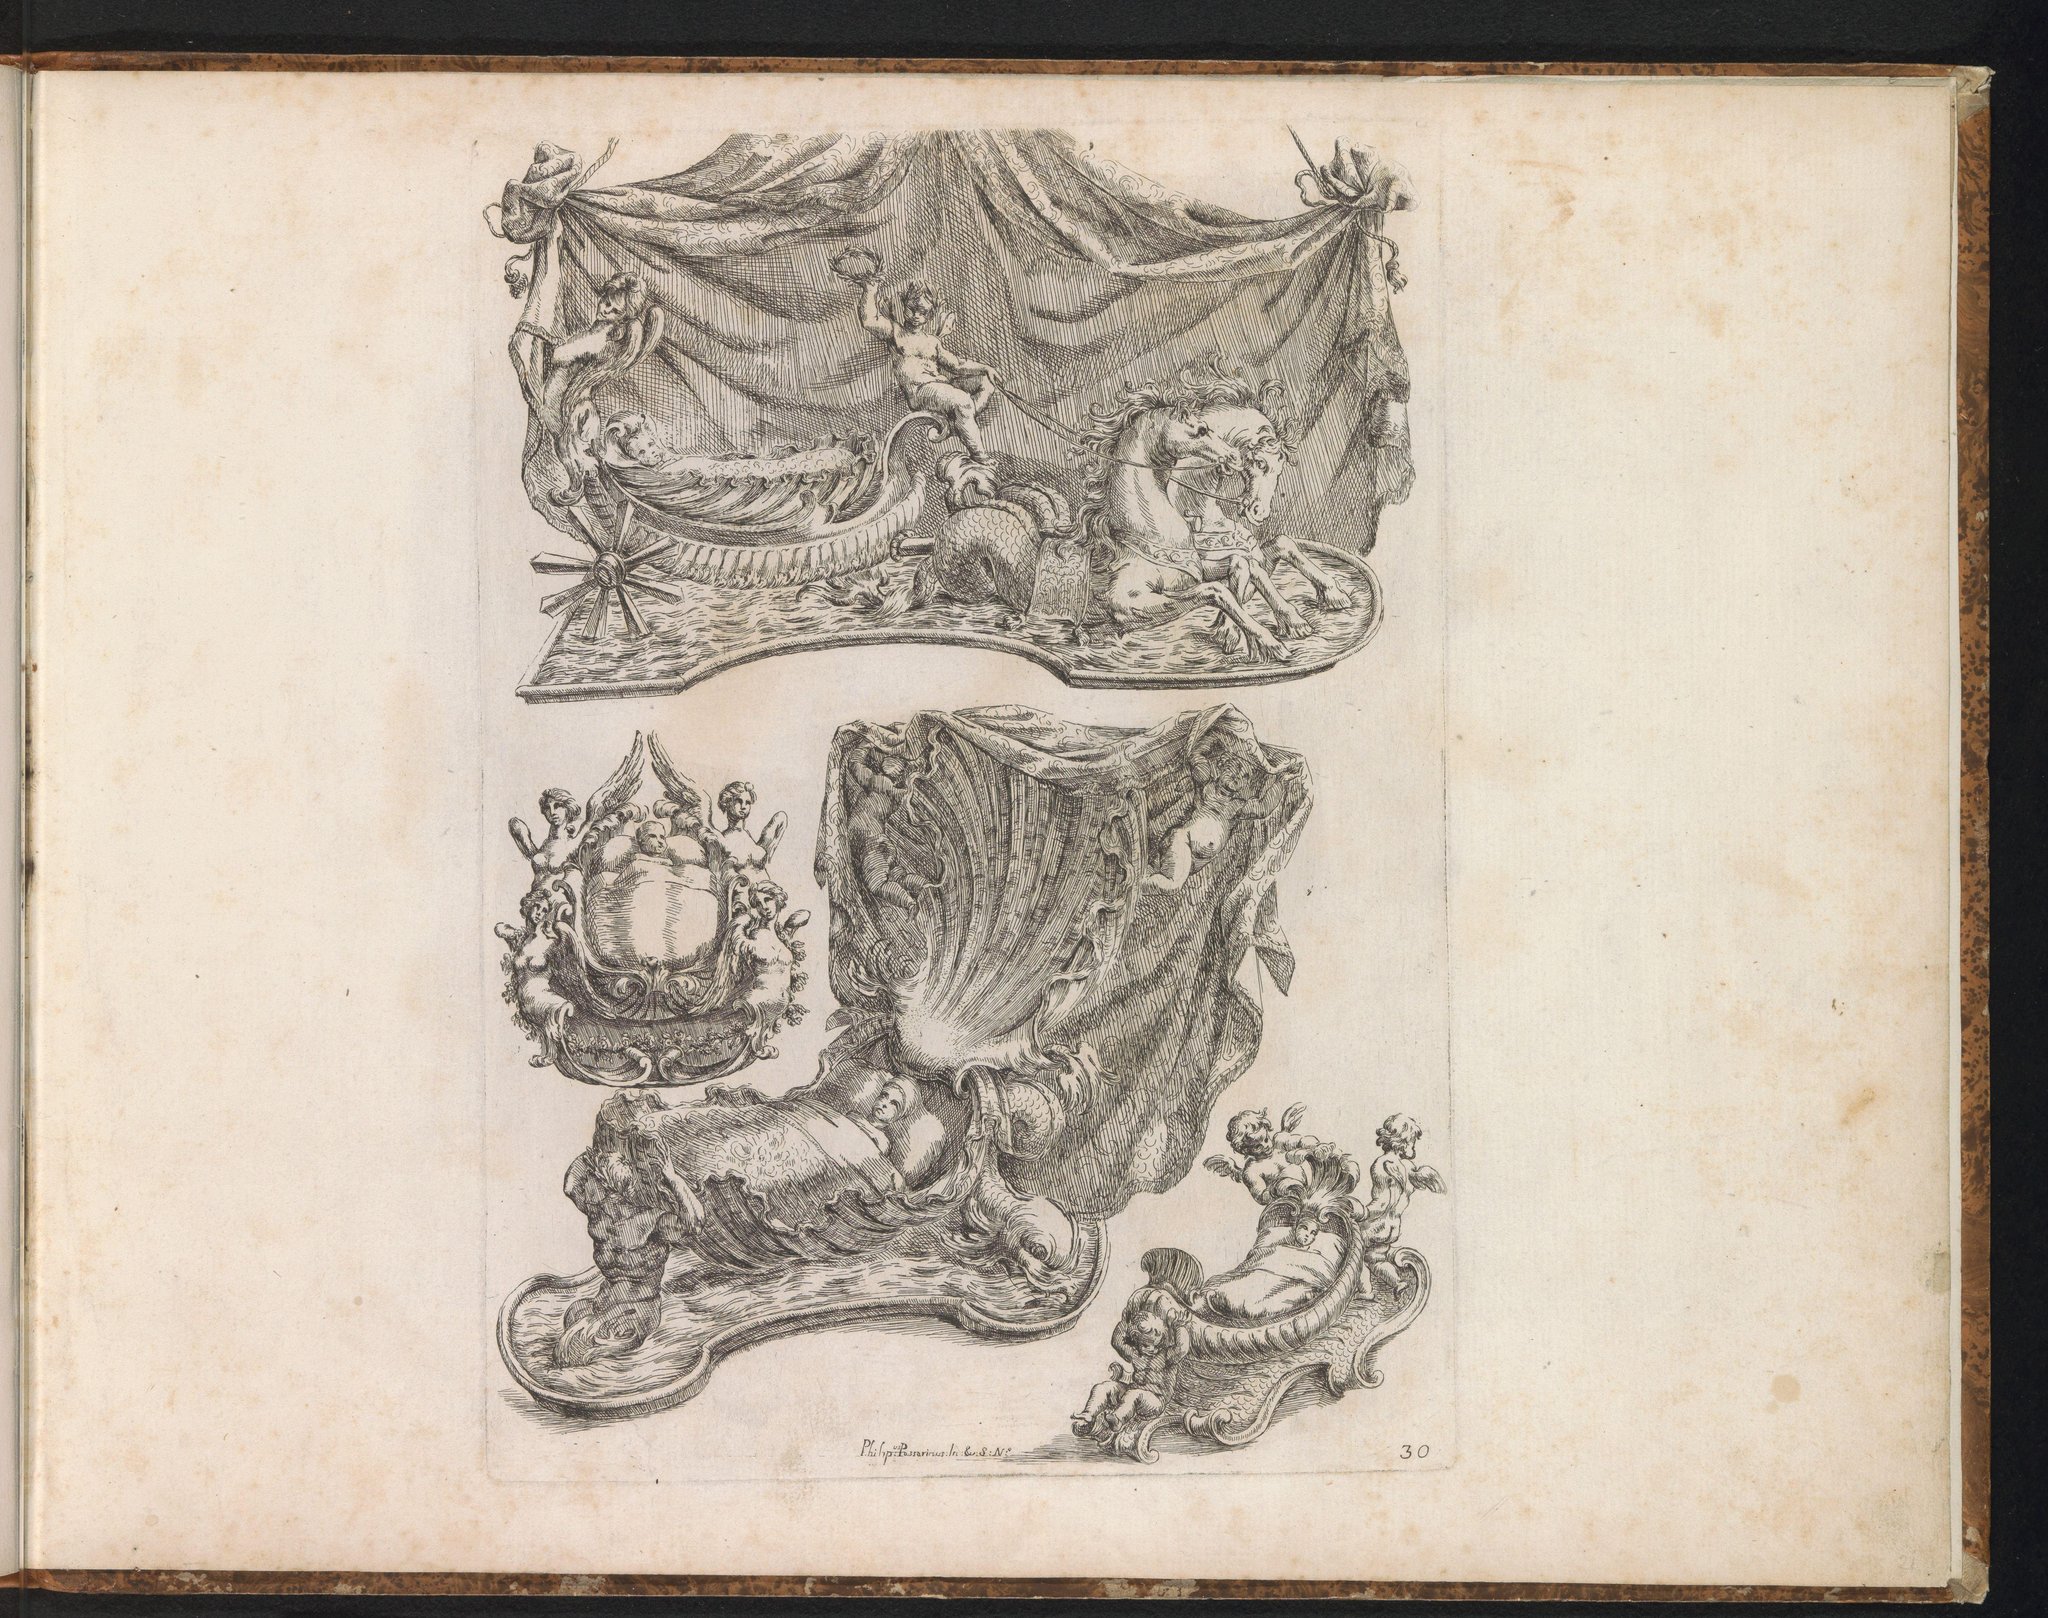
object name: print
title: Four Designs for Children’s Beds in: Nuove invenzioni d’ornamenti d’architettura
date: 1698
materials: paper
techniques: etching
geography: italy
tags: bed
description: This volume contains 22 etchings after drawings by the Roman designer Filippo Passarini. They are exuberant models for a wide range of furniture: from pulpits, organ cases and coffins to canopy beds. One page features four children’s beds, such as the upper one with paddle wheels and pulled by seahorses. This is not about usable furniture, but rather displaying Baroque ingenuity